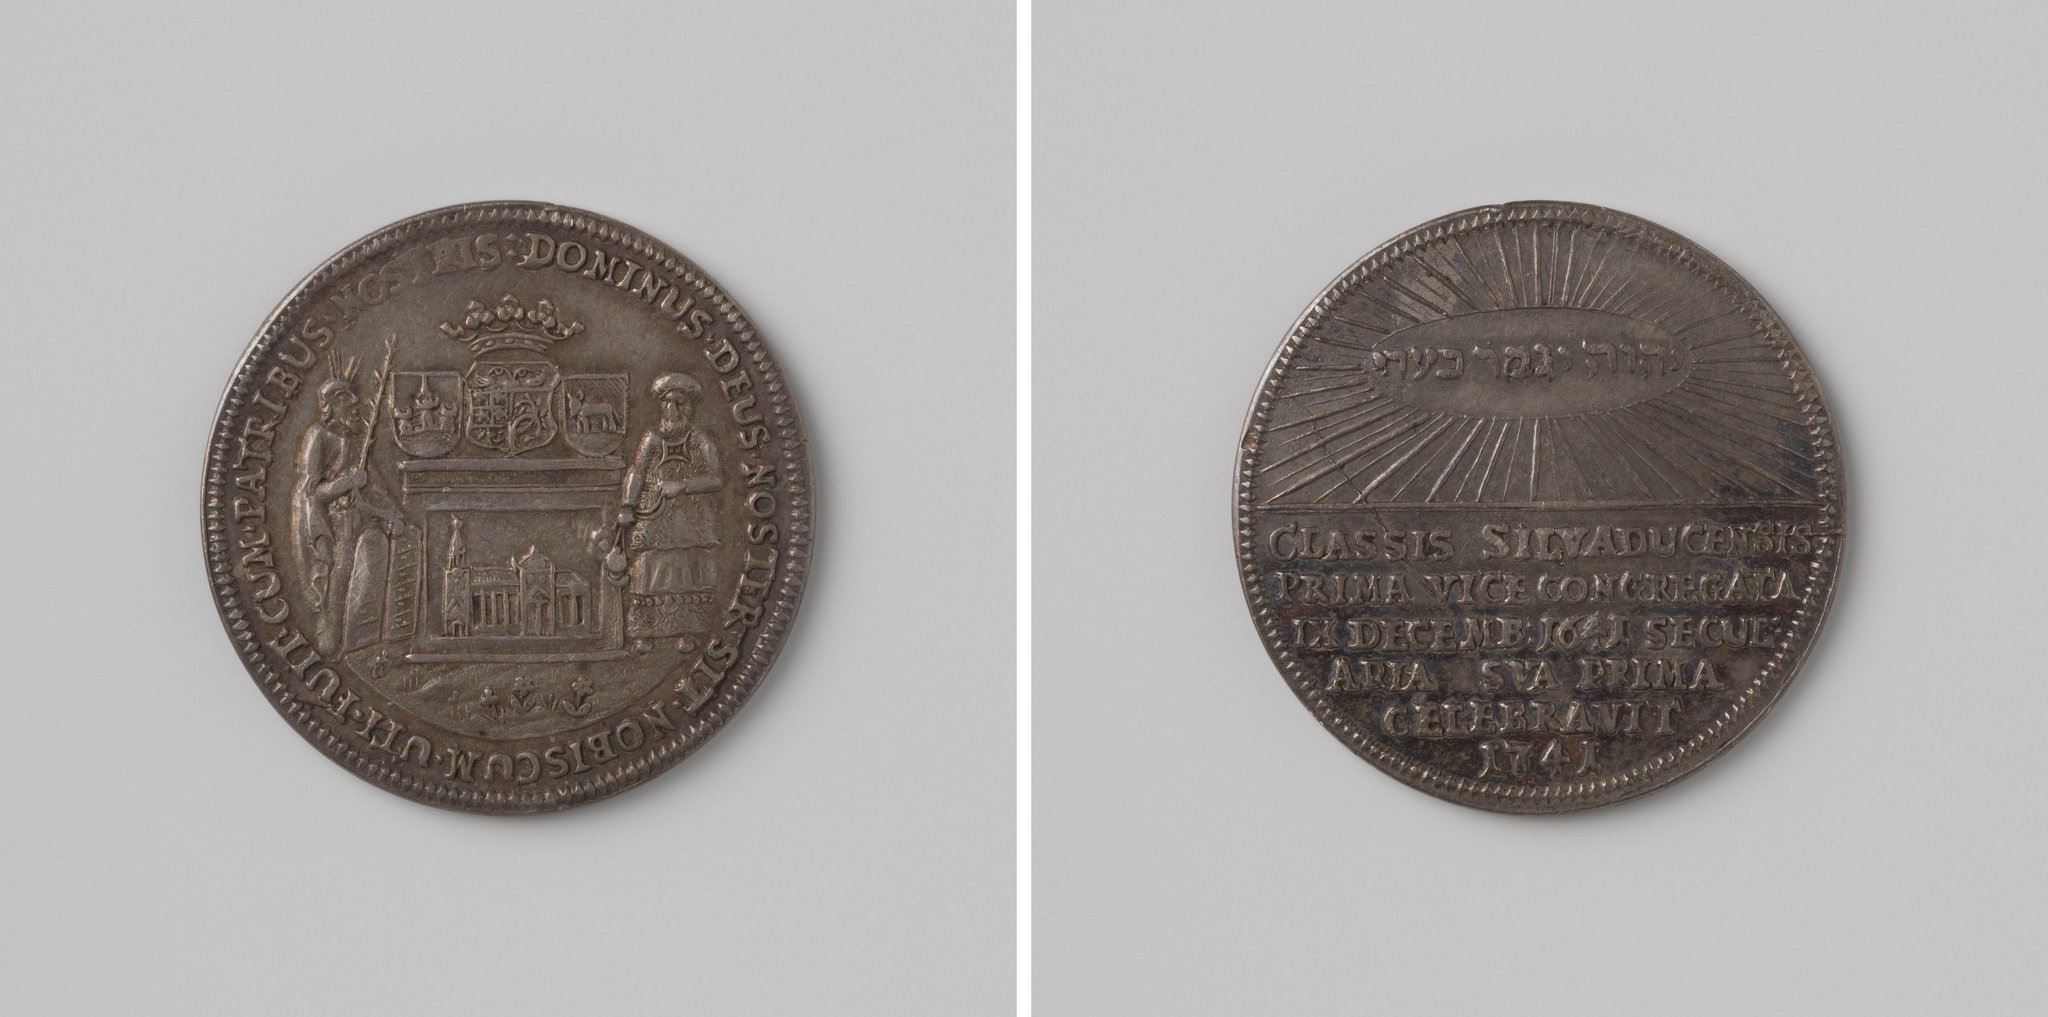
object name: history medal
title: Eerste eeuwfeest van de classis van de hervormde gemeente te 's-Hertogenbosch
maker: Anonymous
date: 1741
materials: silver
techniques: striking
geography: netherlands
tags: den bosch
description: Zilveren penning. Voorzijde: afbeelding van een kerk onder een gekroond en twee andere wapenschilden, geflankeerd door Mozes en Aaron binnen omschrift. Keerzijde: naam Jehova in het Hebreeuws binnen een stralenkrans boven opschrift